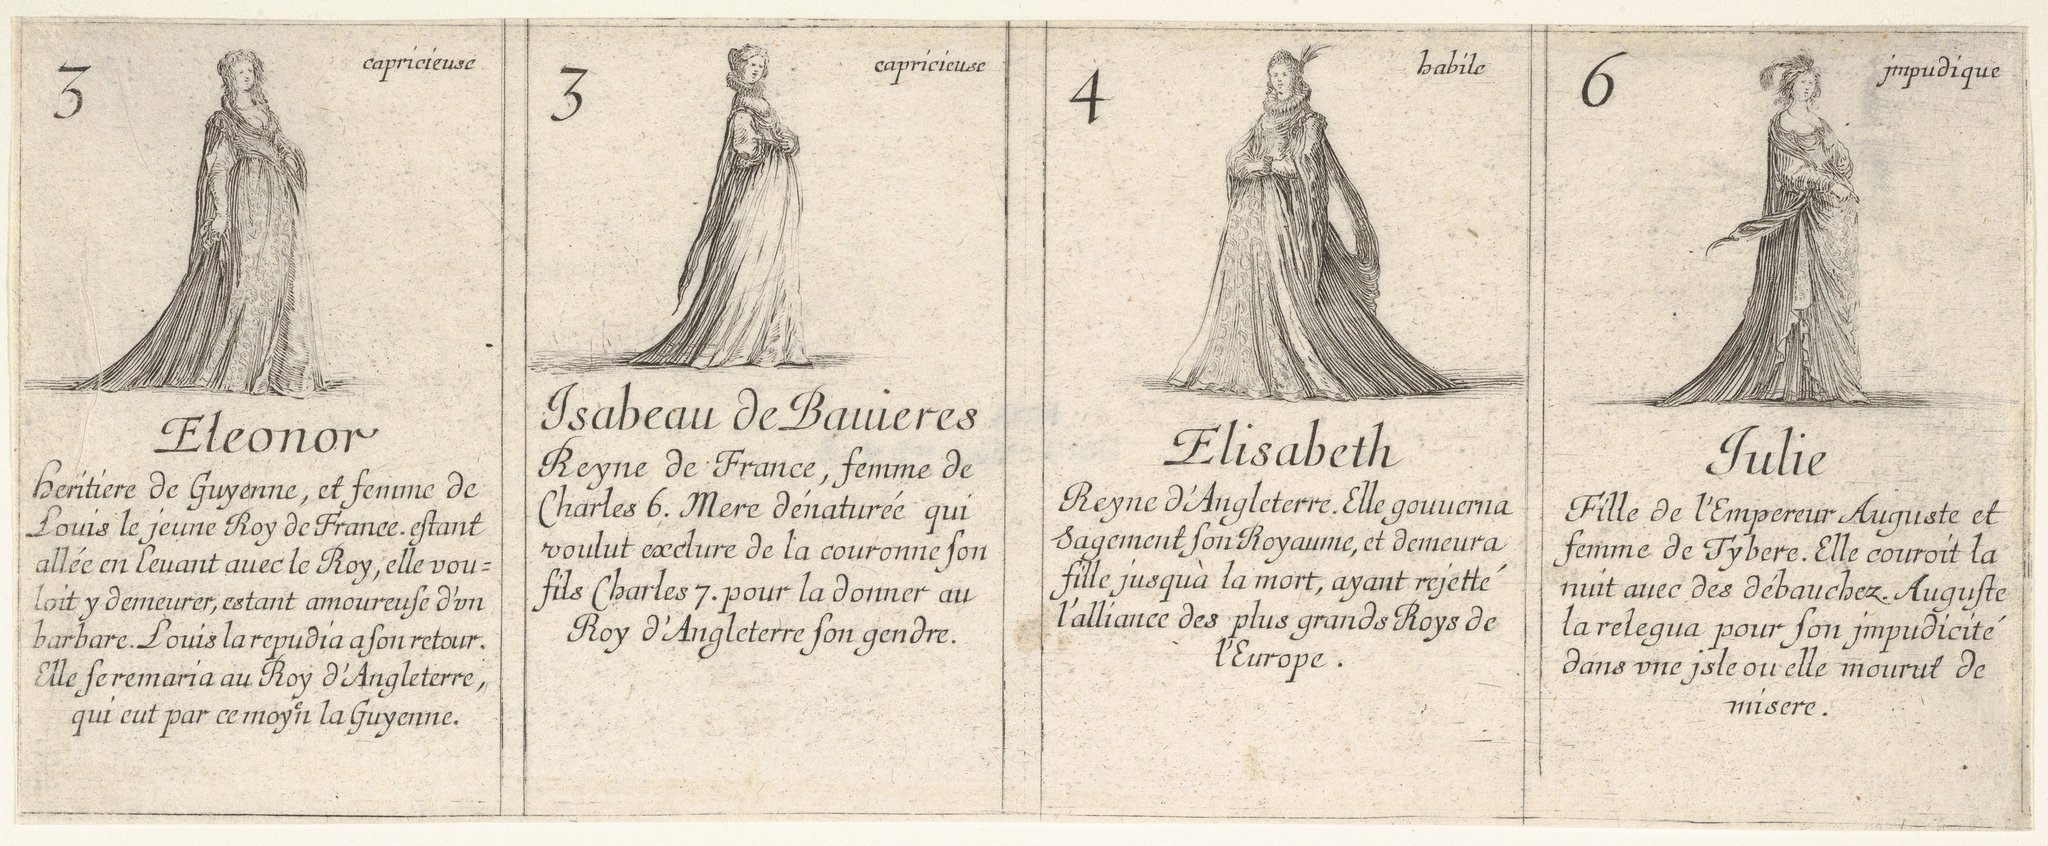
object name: print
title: Eleonor, Isabeau de Bauieres, Elisabeth, and Julie, from "The Game of Queens" (Le Jeu des Reines Renommées)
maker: stefano della bella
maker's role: artist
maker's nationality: italian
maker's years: 1610-1664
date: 1644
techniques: etching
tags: queens